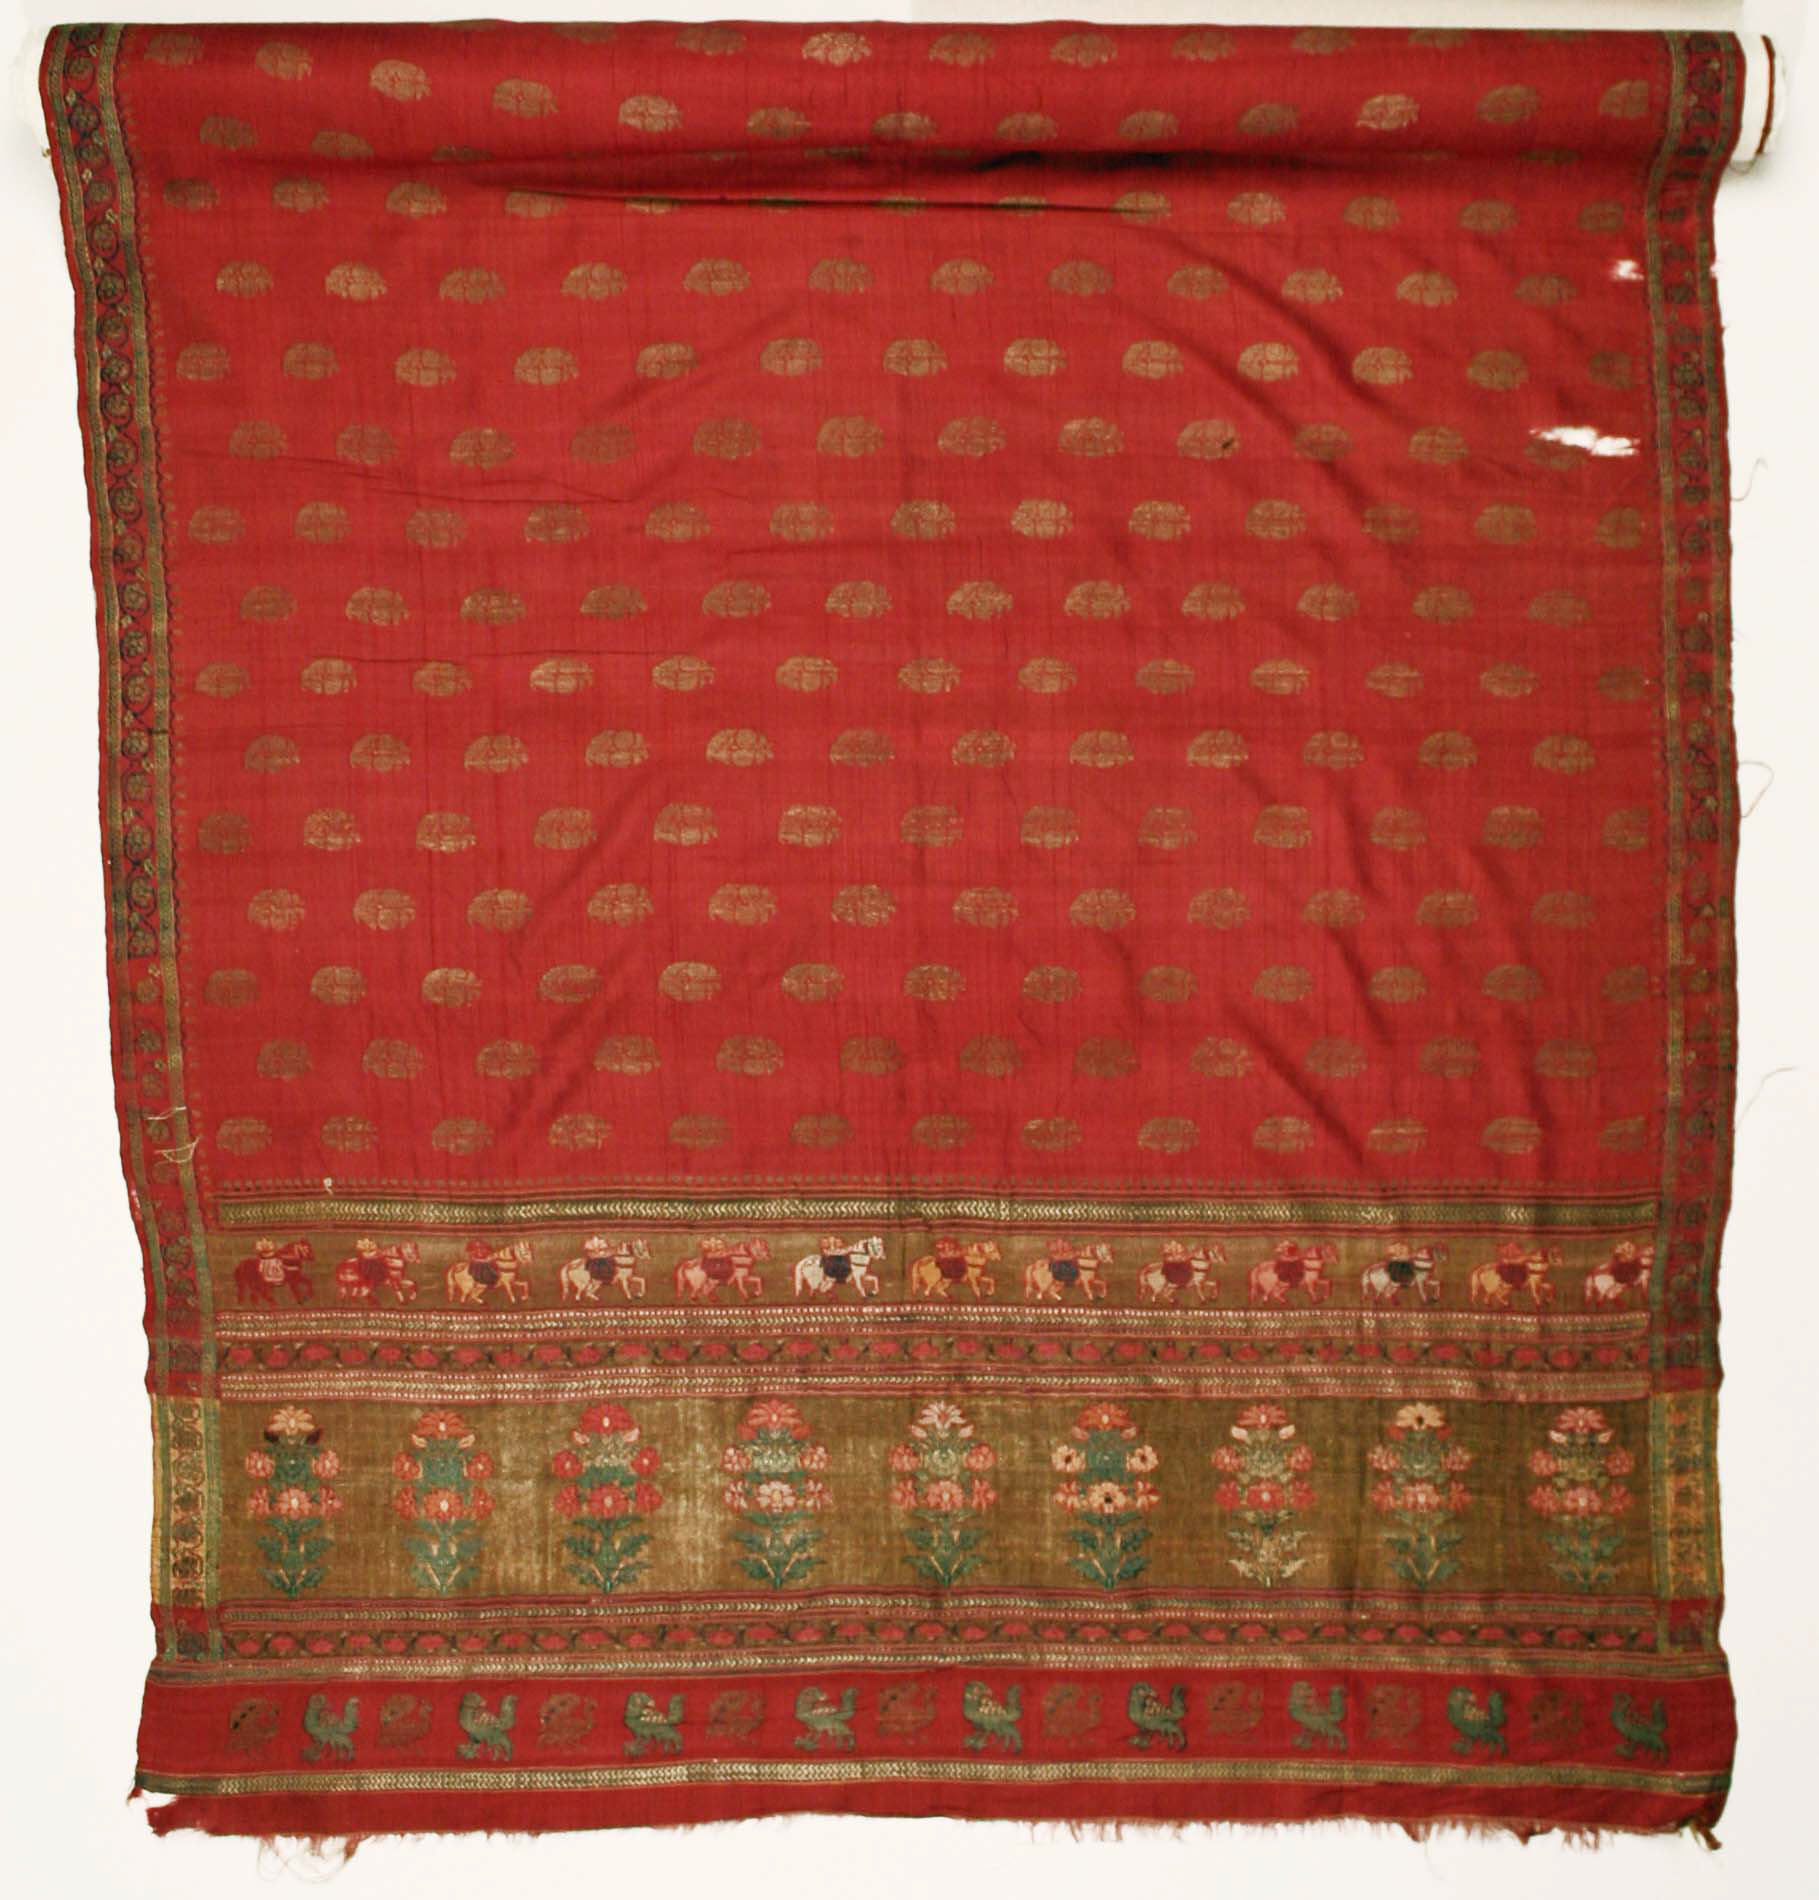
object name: sari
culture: indian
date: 1701-1800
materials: silk